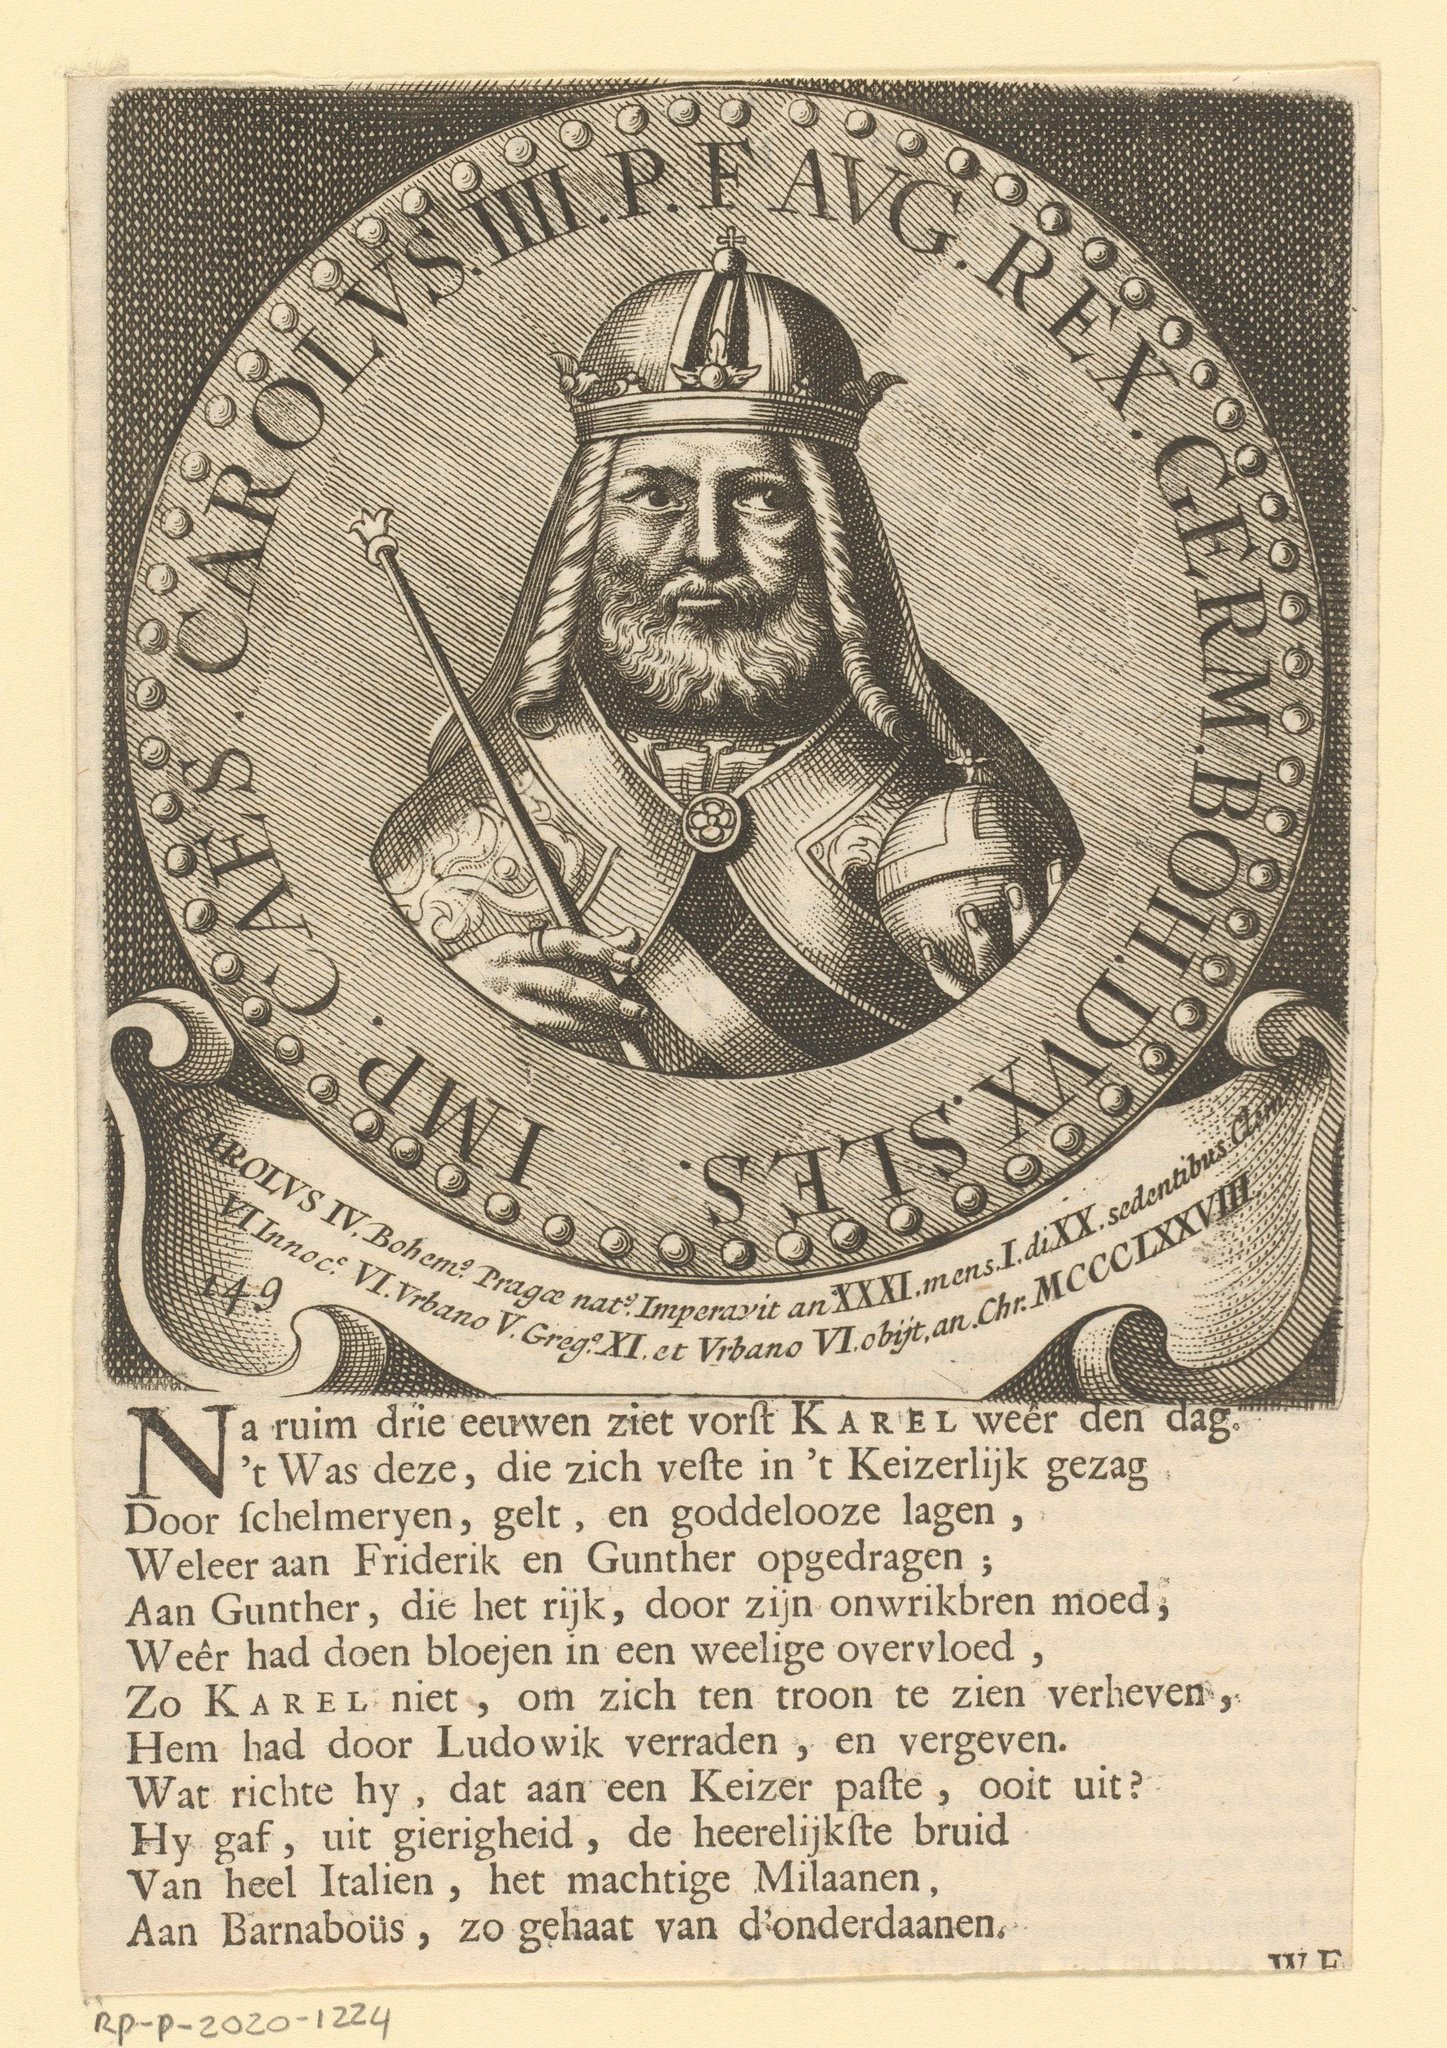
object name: print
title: Portret van Karel IV, keizer van het Heilige Roomse Rijk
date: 1697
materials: paper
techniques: engraving, etching, letterpress printing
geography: utrecht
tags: prague, crown (symbol of sovereignty), sceptre, staff (symbol of sovereignty), historical persons, emperor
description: Prent uit: Bogaert, Abraham. De Roomsche monarchy, vertoont in de muntbeelden der westersche en oostersche keizeren (...). Utrecht: François Halma en Willem van de Water, 1697, p. 407. Eerste staat verschenen als grotere prent met 12 portretten, gedateerd 1695.